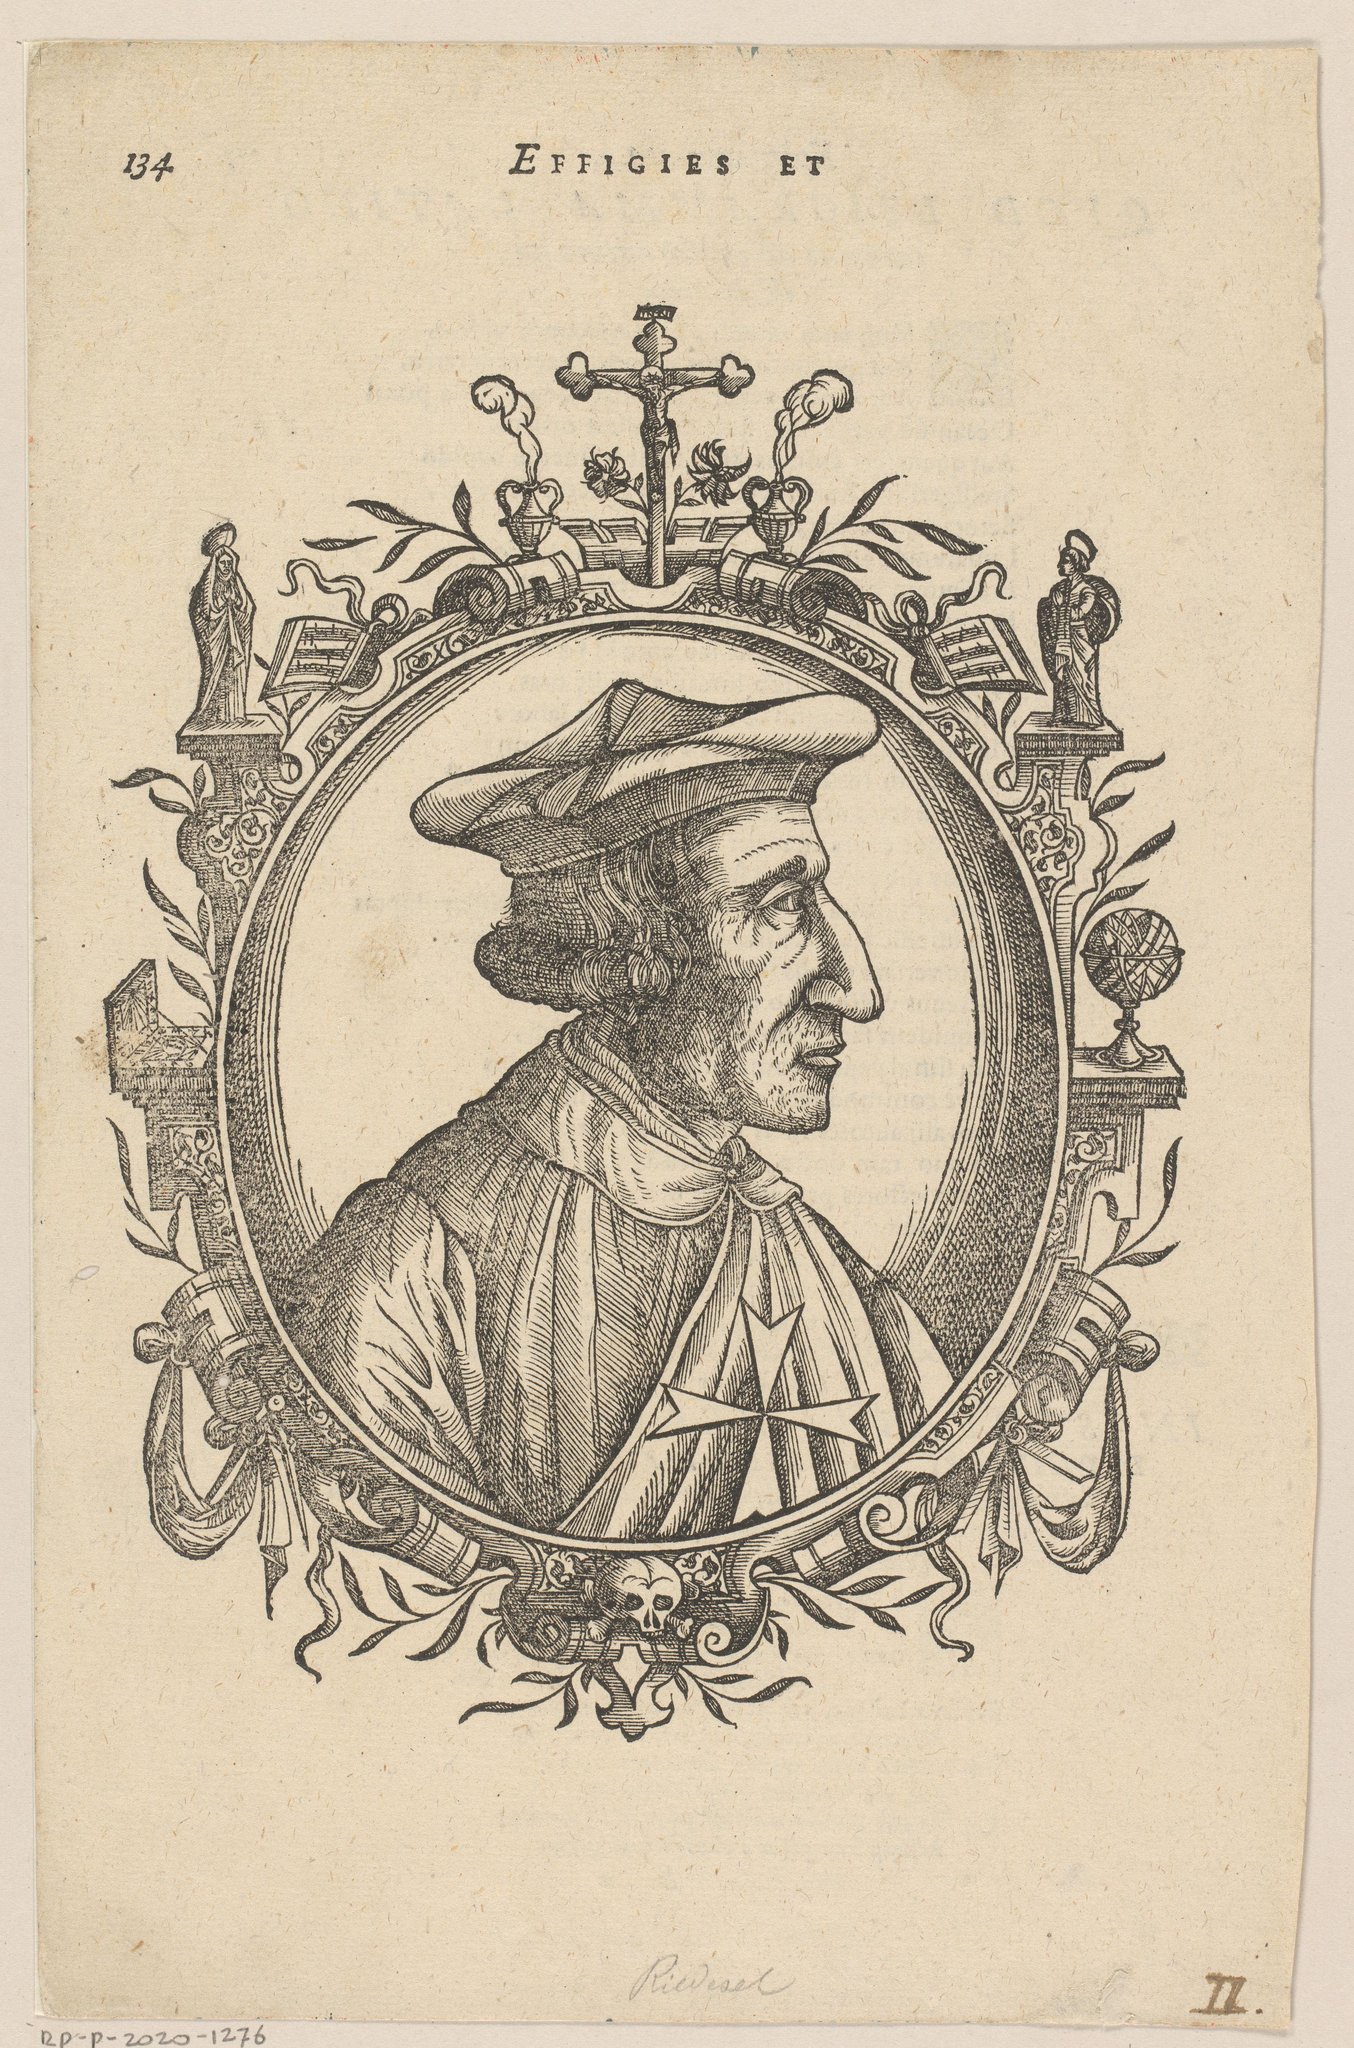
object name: book illustration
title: Portret van een onbekende man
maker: Anonymous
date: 1550-1649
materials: paper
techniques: letterpress printing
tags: (human) skull, historical persons, the cross ~ symbols of christ, globe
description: Op het verso van de prent staat een Latijnse en een Griekse tekst. In de Latijnse tekst worden de namen D. Philippi Riedesel à Kamberg en auteur Ioanne Ritterio genoemd. Mogelijk is de eerstgenoemde de geportretteerde persoon.